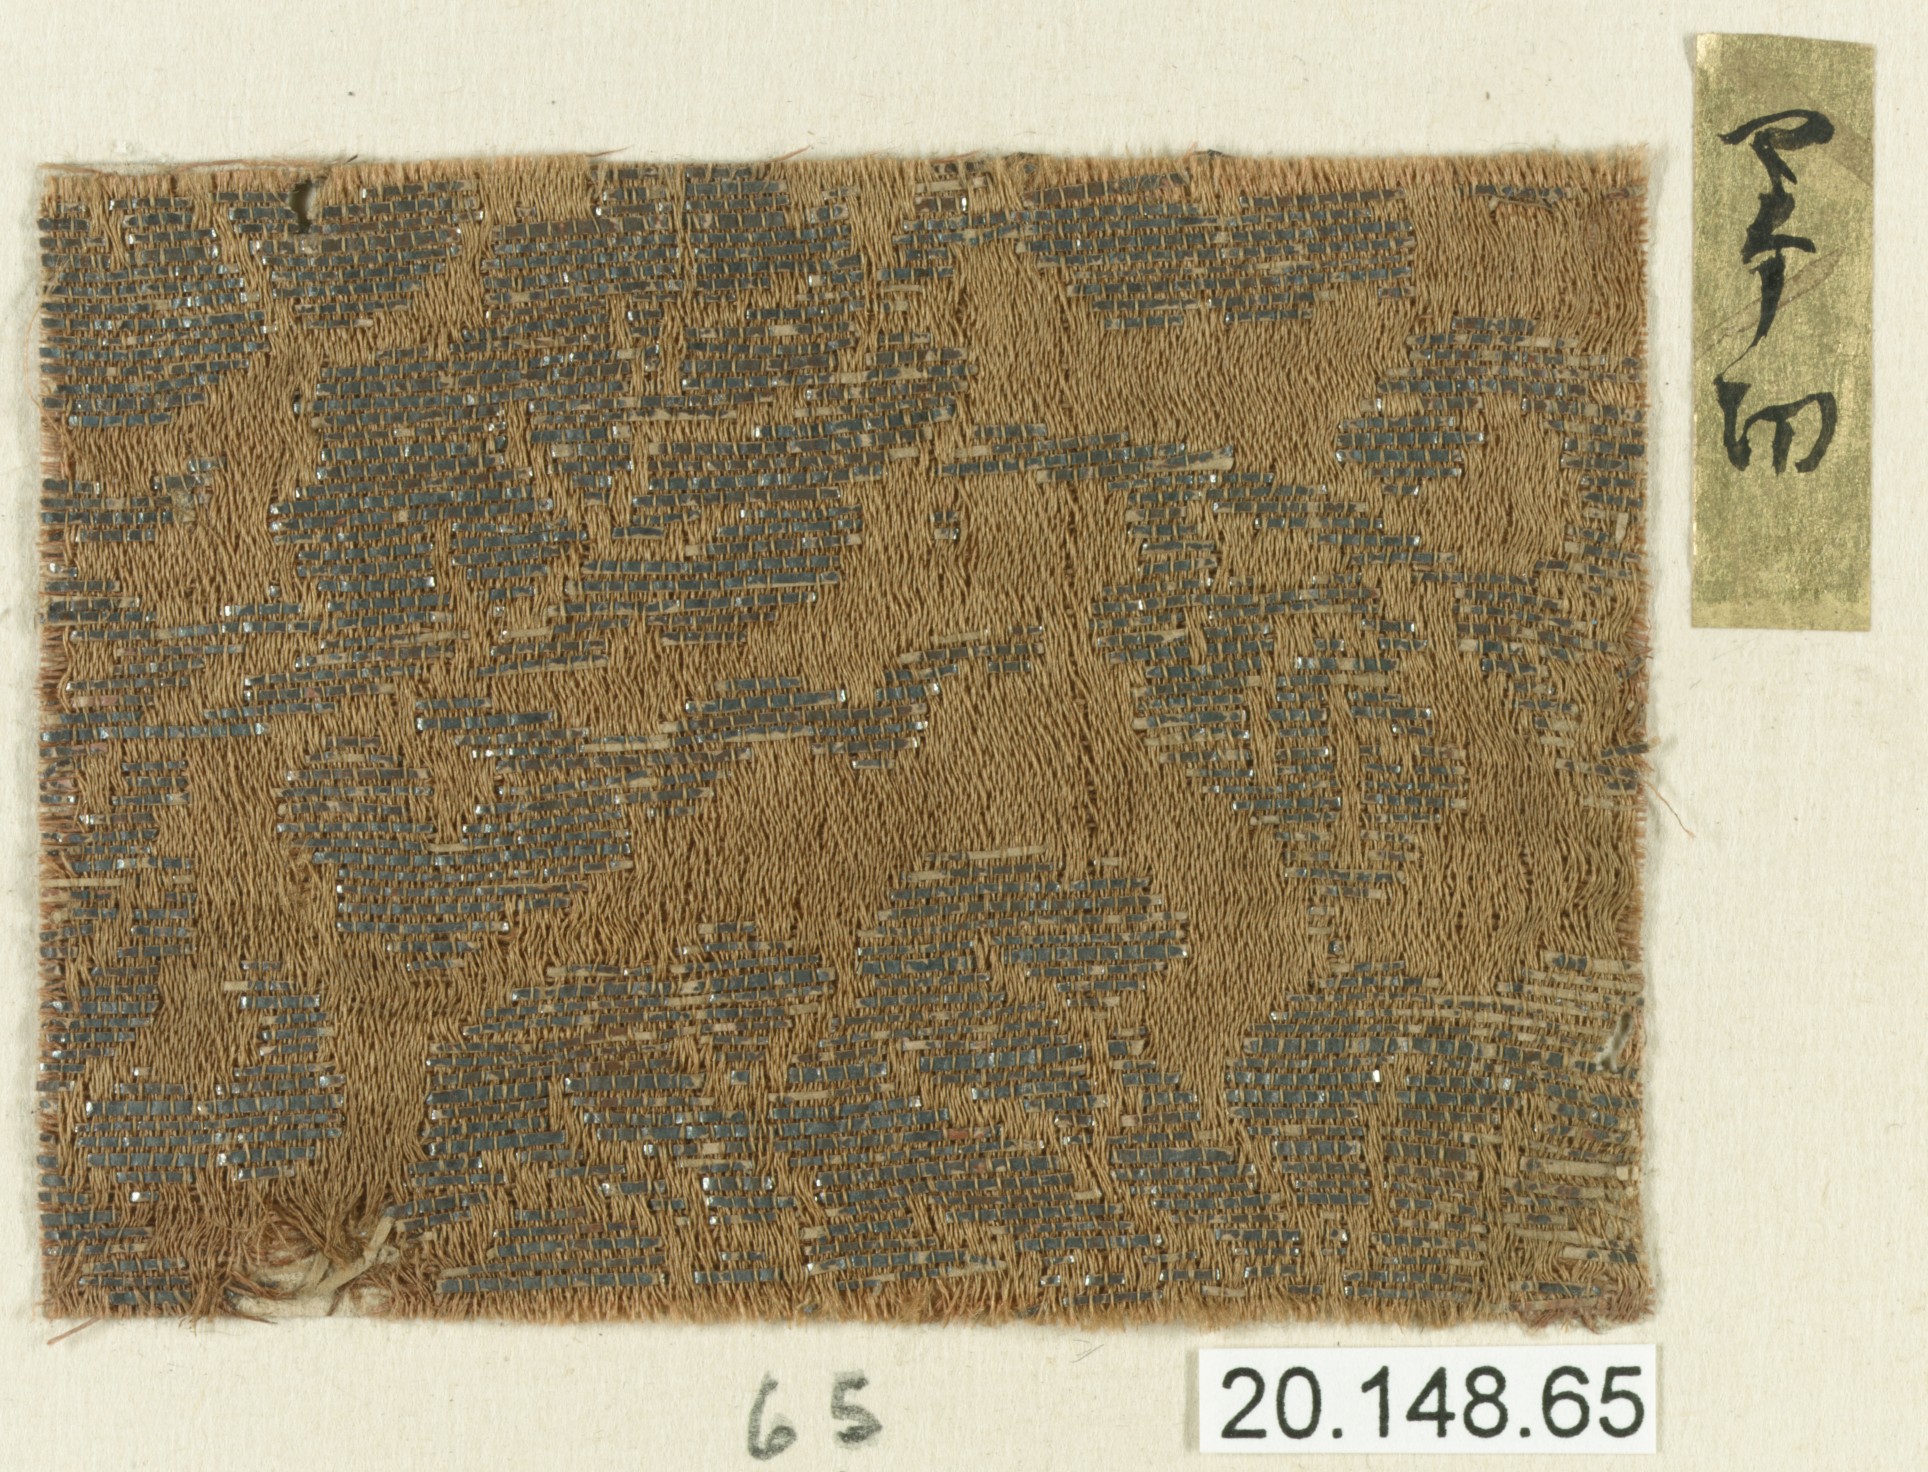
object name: piece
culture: japanese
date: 1501-1600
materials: silk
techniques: compound weave